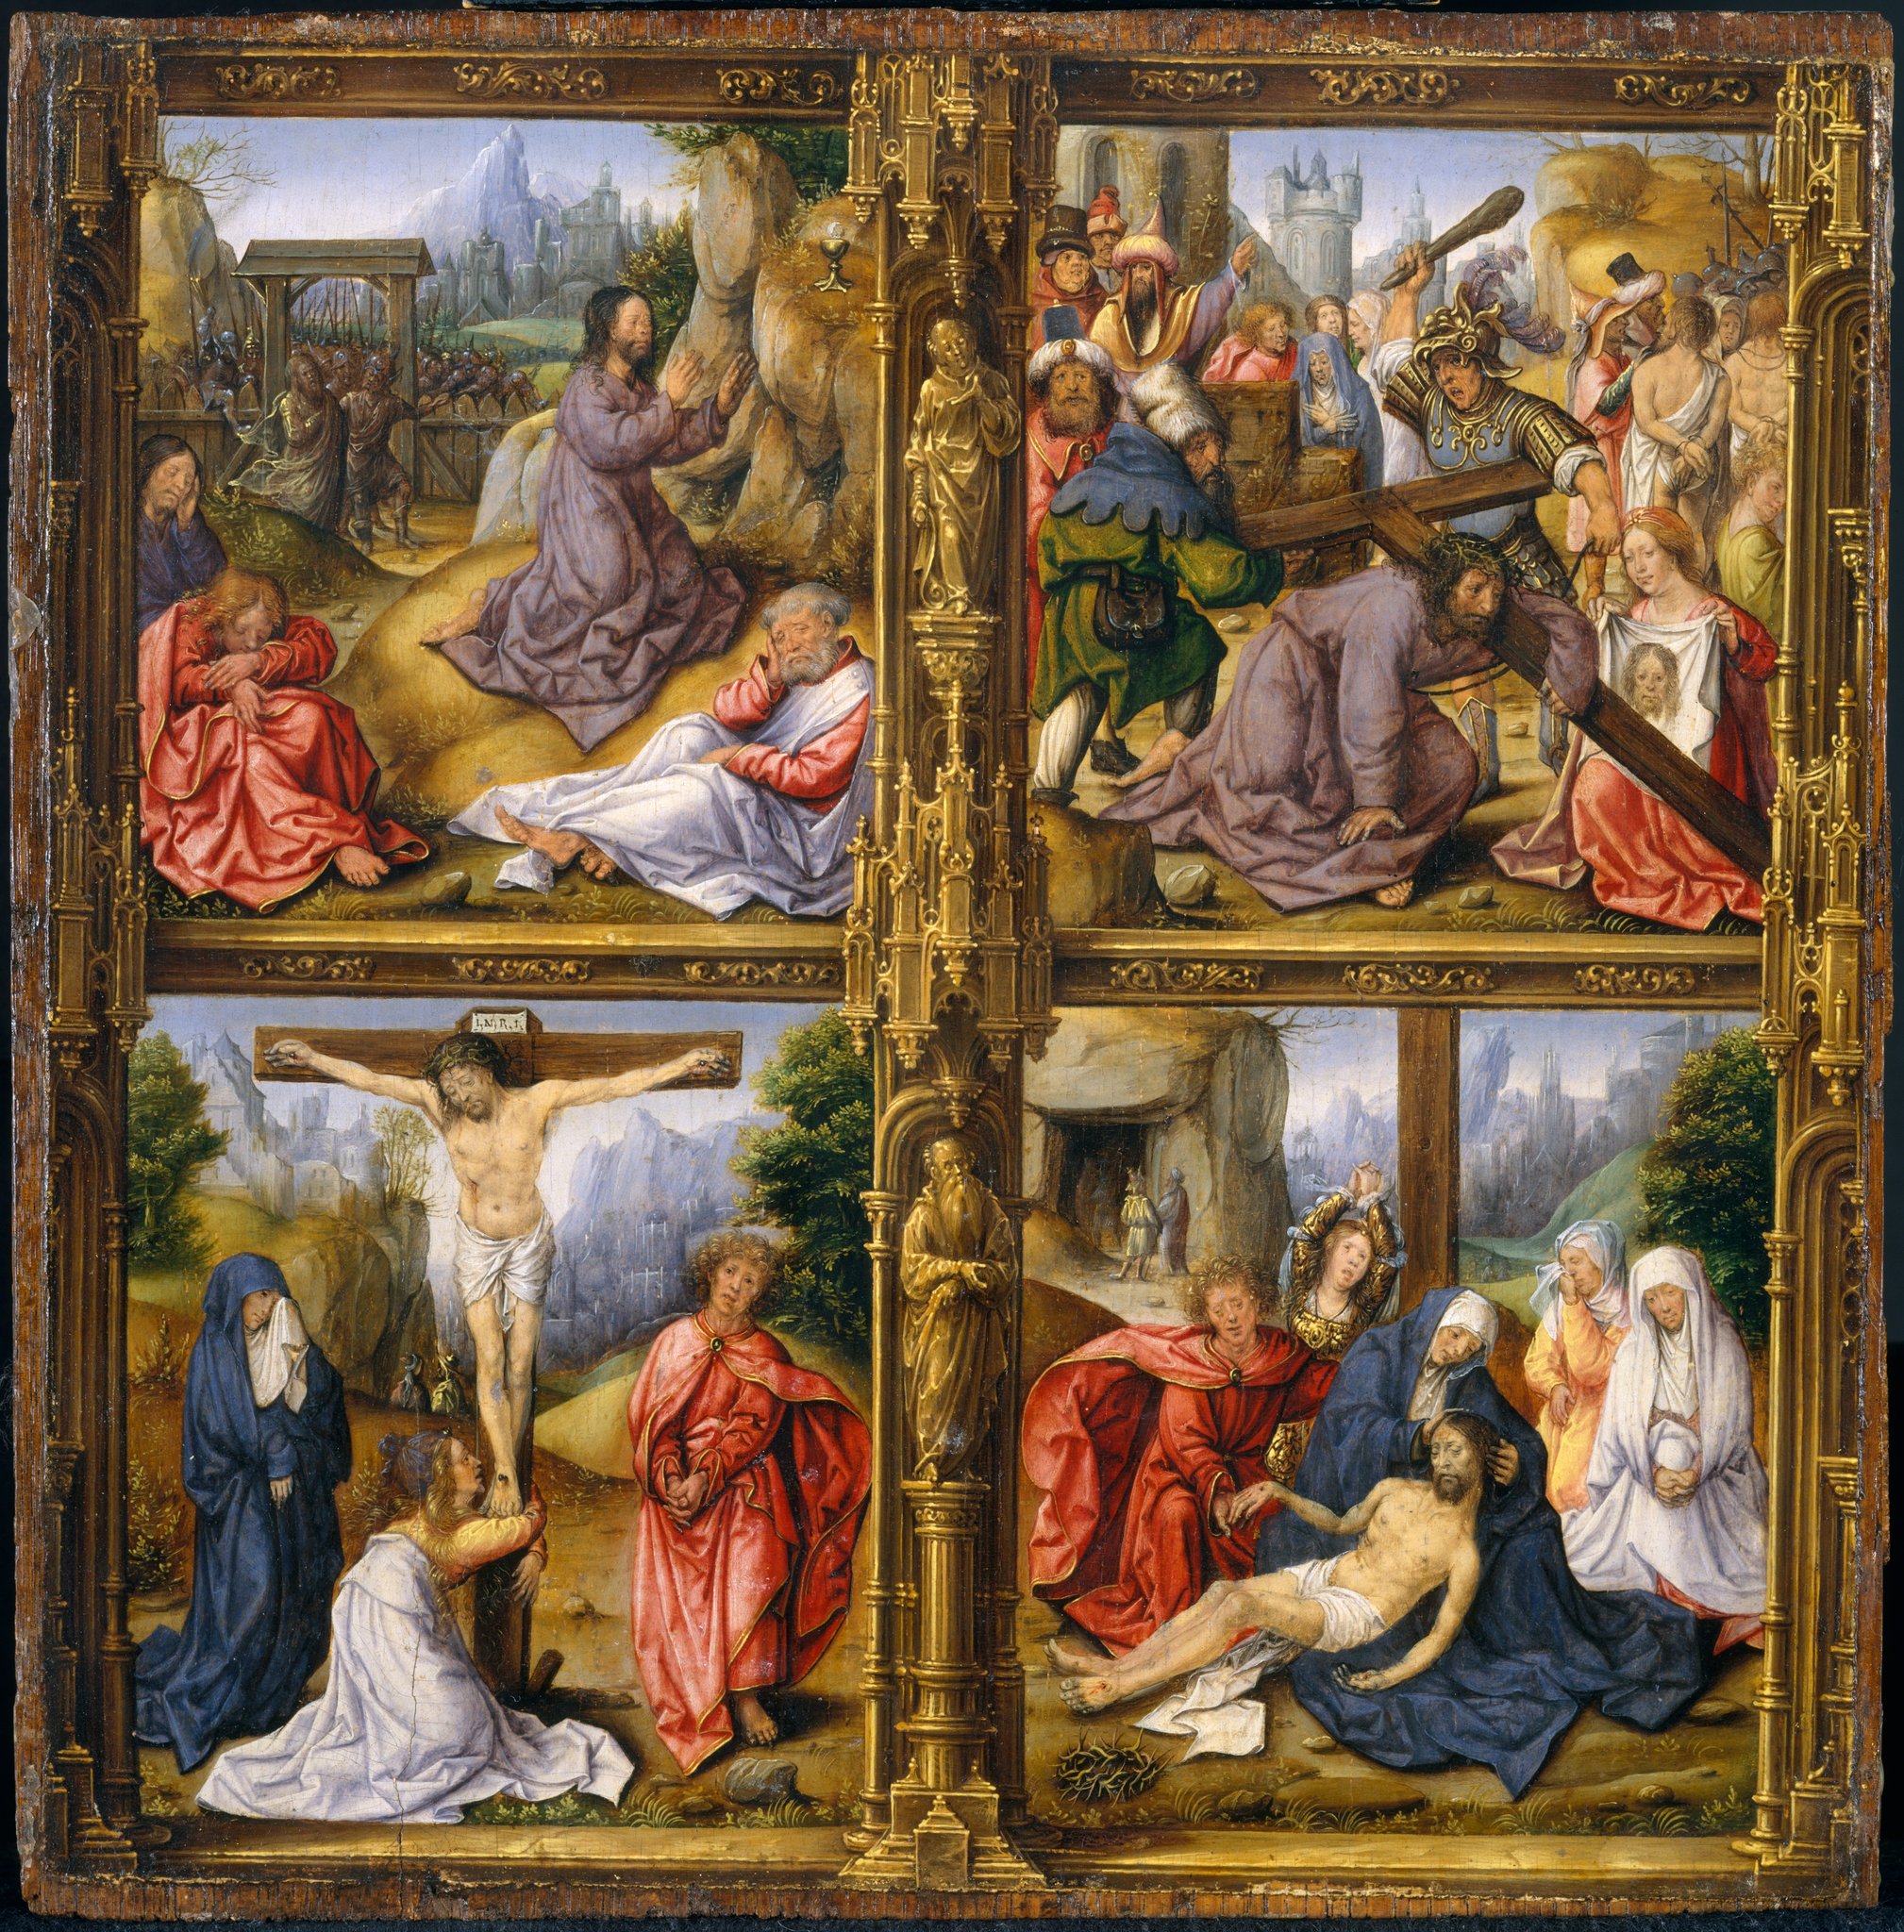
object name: painting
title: Four Scenes from the Passion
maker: bernard van orley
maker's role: artist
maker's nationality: netherlandish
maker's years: 1492-1542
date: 1520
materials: oil, wood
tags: christ,mary magdalene,saint john the evangelist,virgin mary,bearing the cross,crucifixion,lamentation,agony in the garden